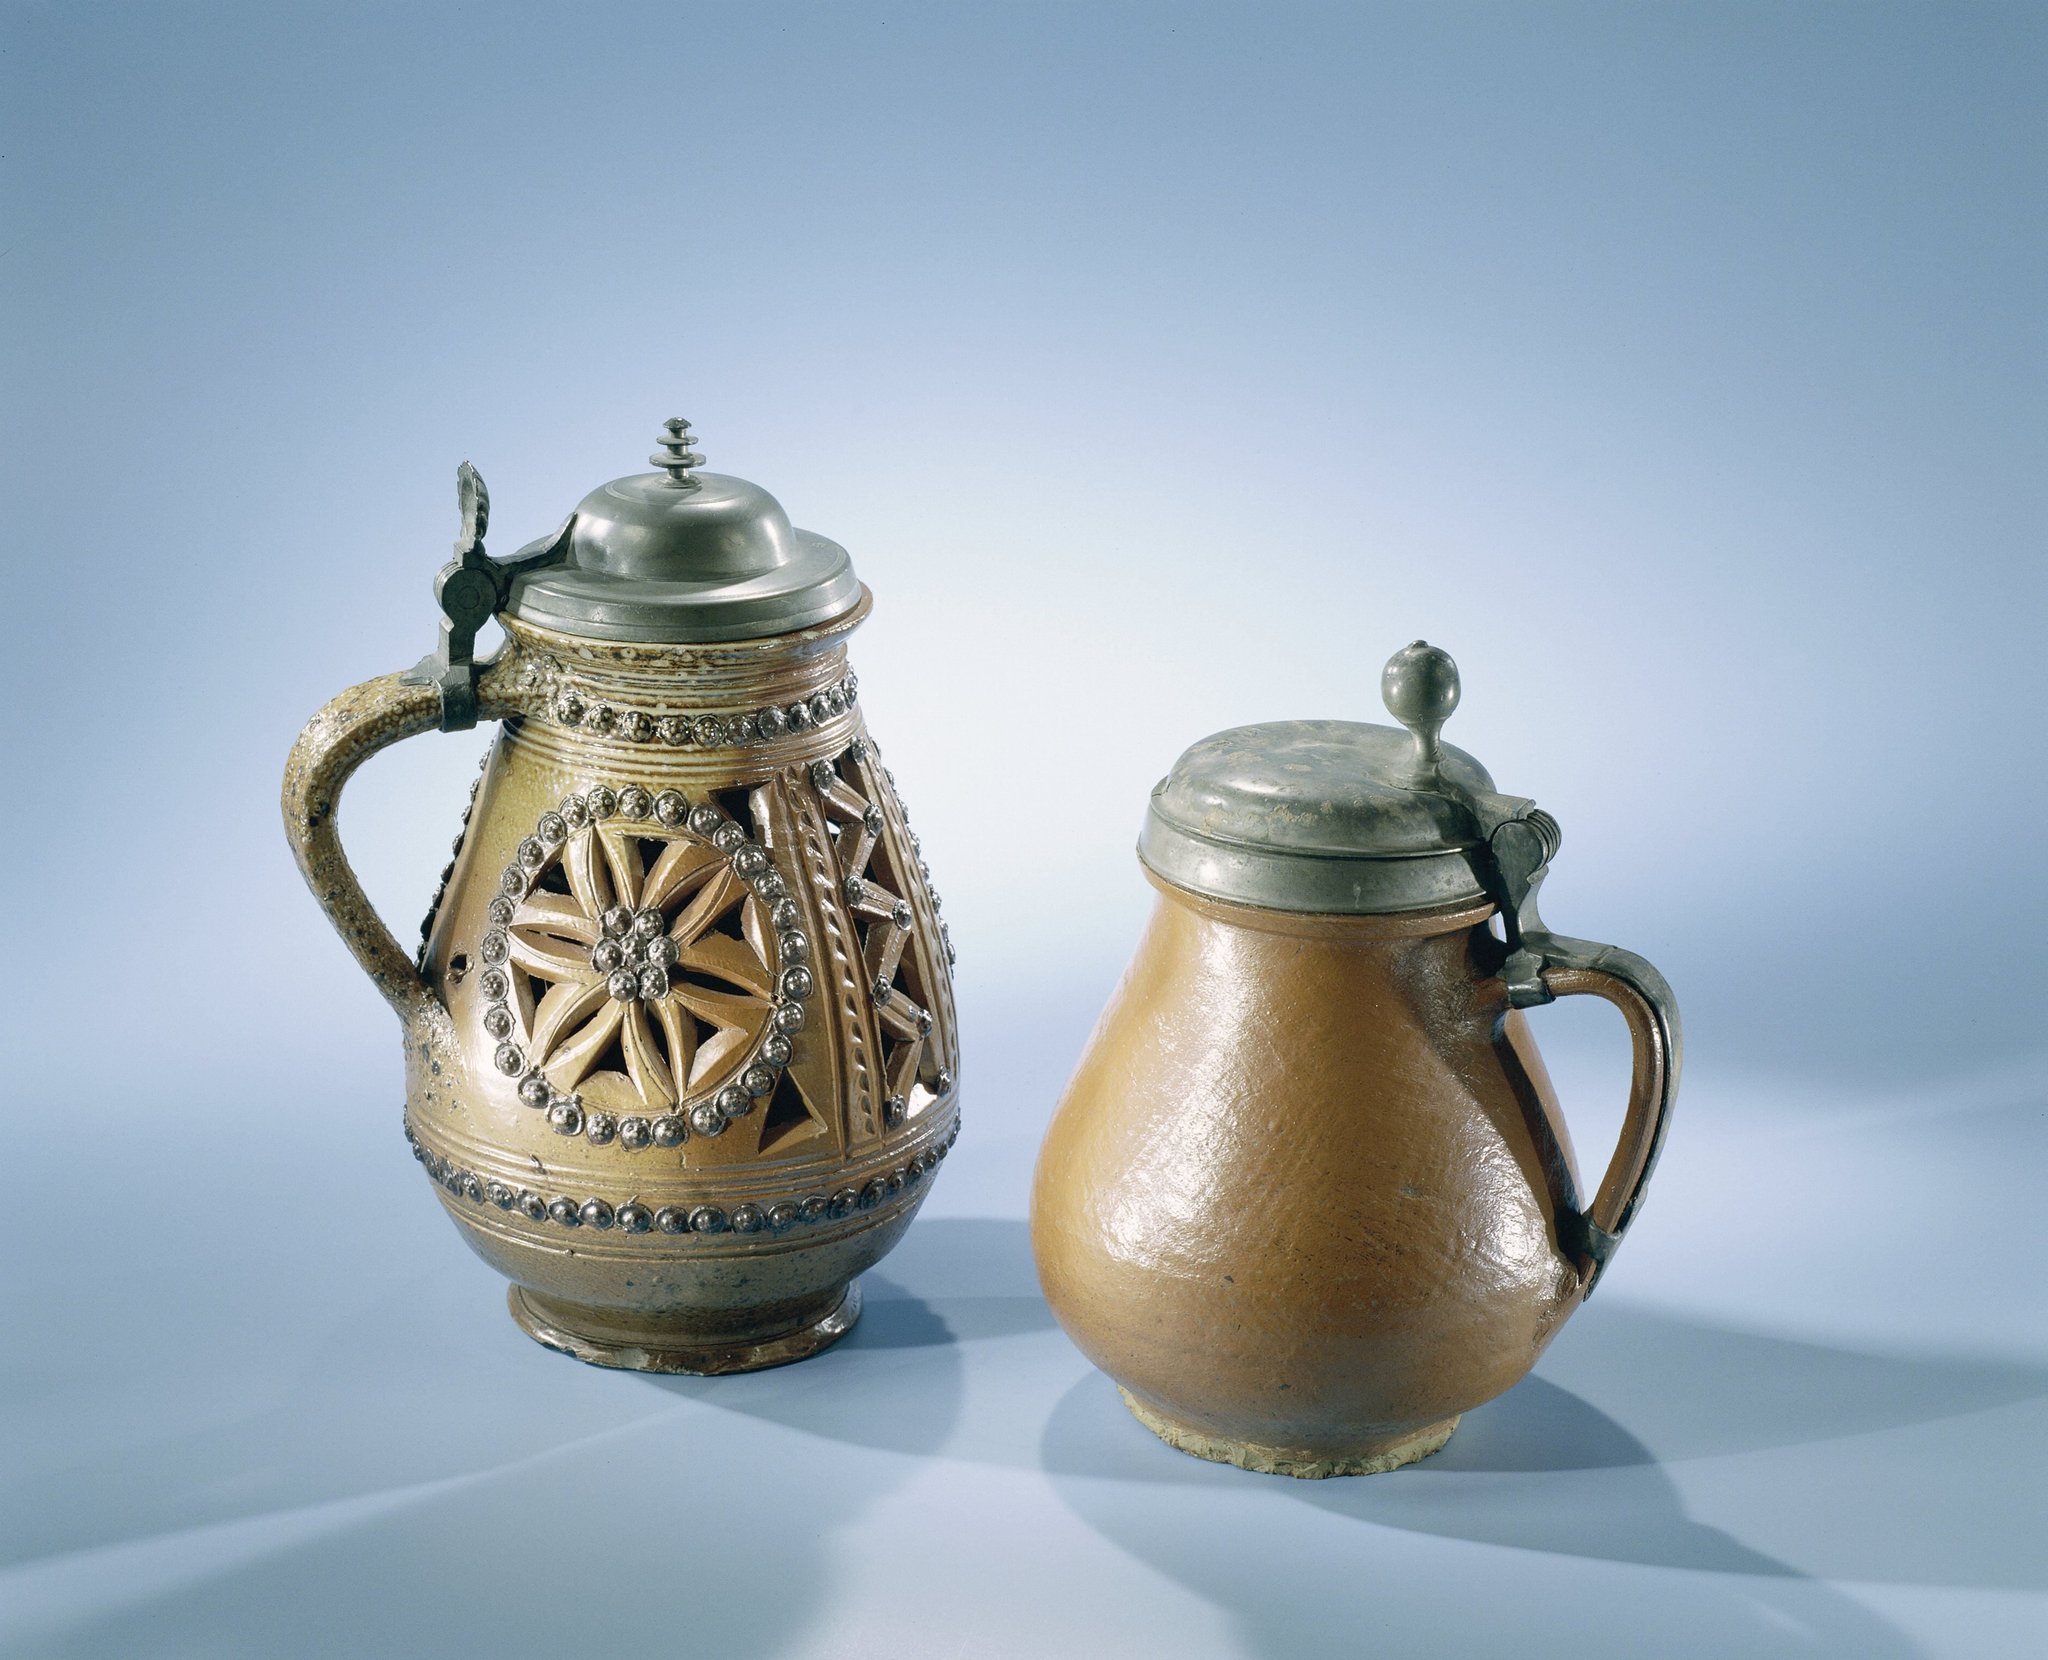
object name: jug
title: Jug with pierced sides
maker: Anonymous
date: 1625-1649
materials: glaze, stoneware, tin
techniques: embroidery, firing, forming, relief, turning, vitrification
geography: altenburg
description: Tankard with a double wall. Saxony, Altenburg, c. 1630 - 1640. On loan from the Koninklijk Oudheidkundig Genootschap.